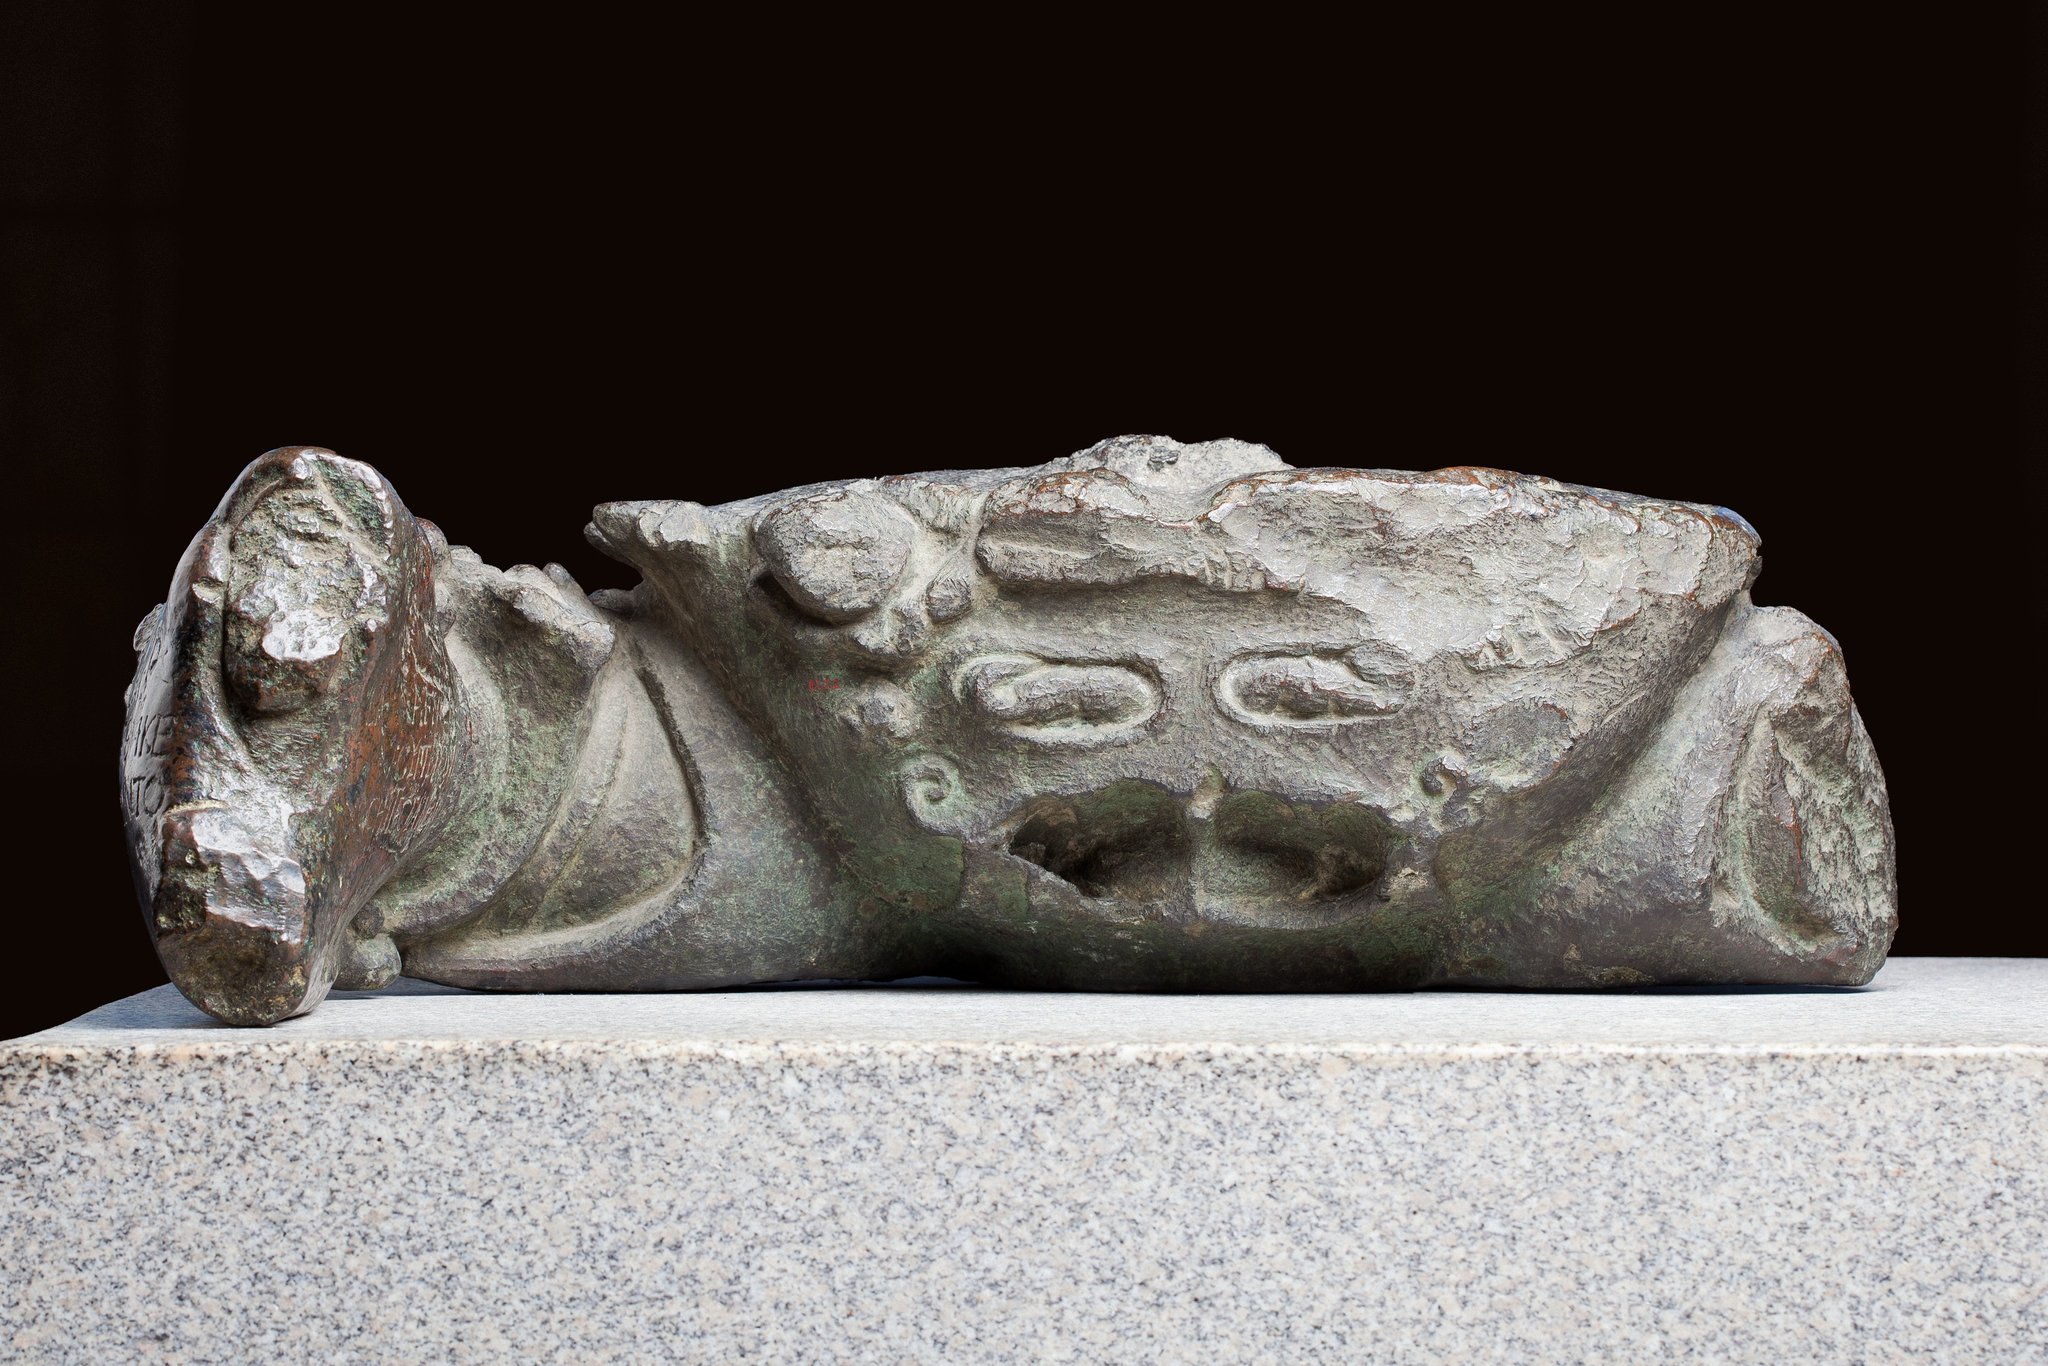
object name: obelisk support, crab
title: Crab from "Cleopatra's Needle"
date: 13 BCE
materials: bronze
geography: egypt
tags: crabs